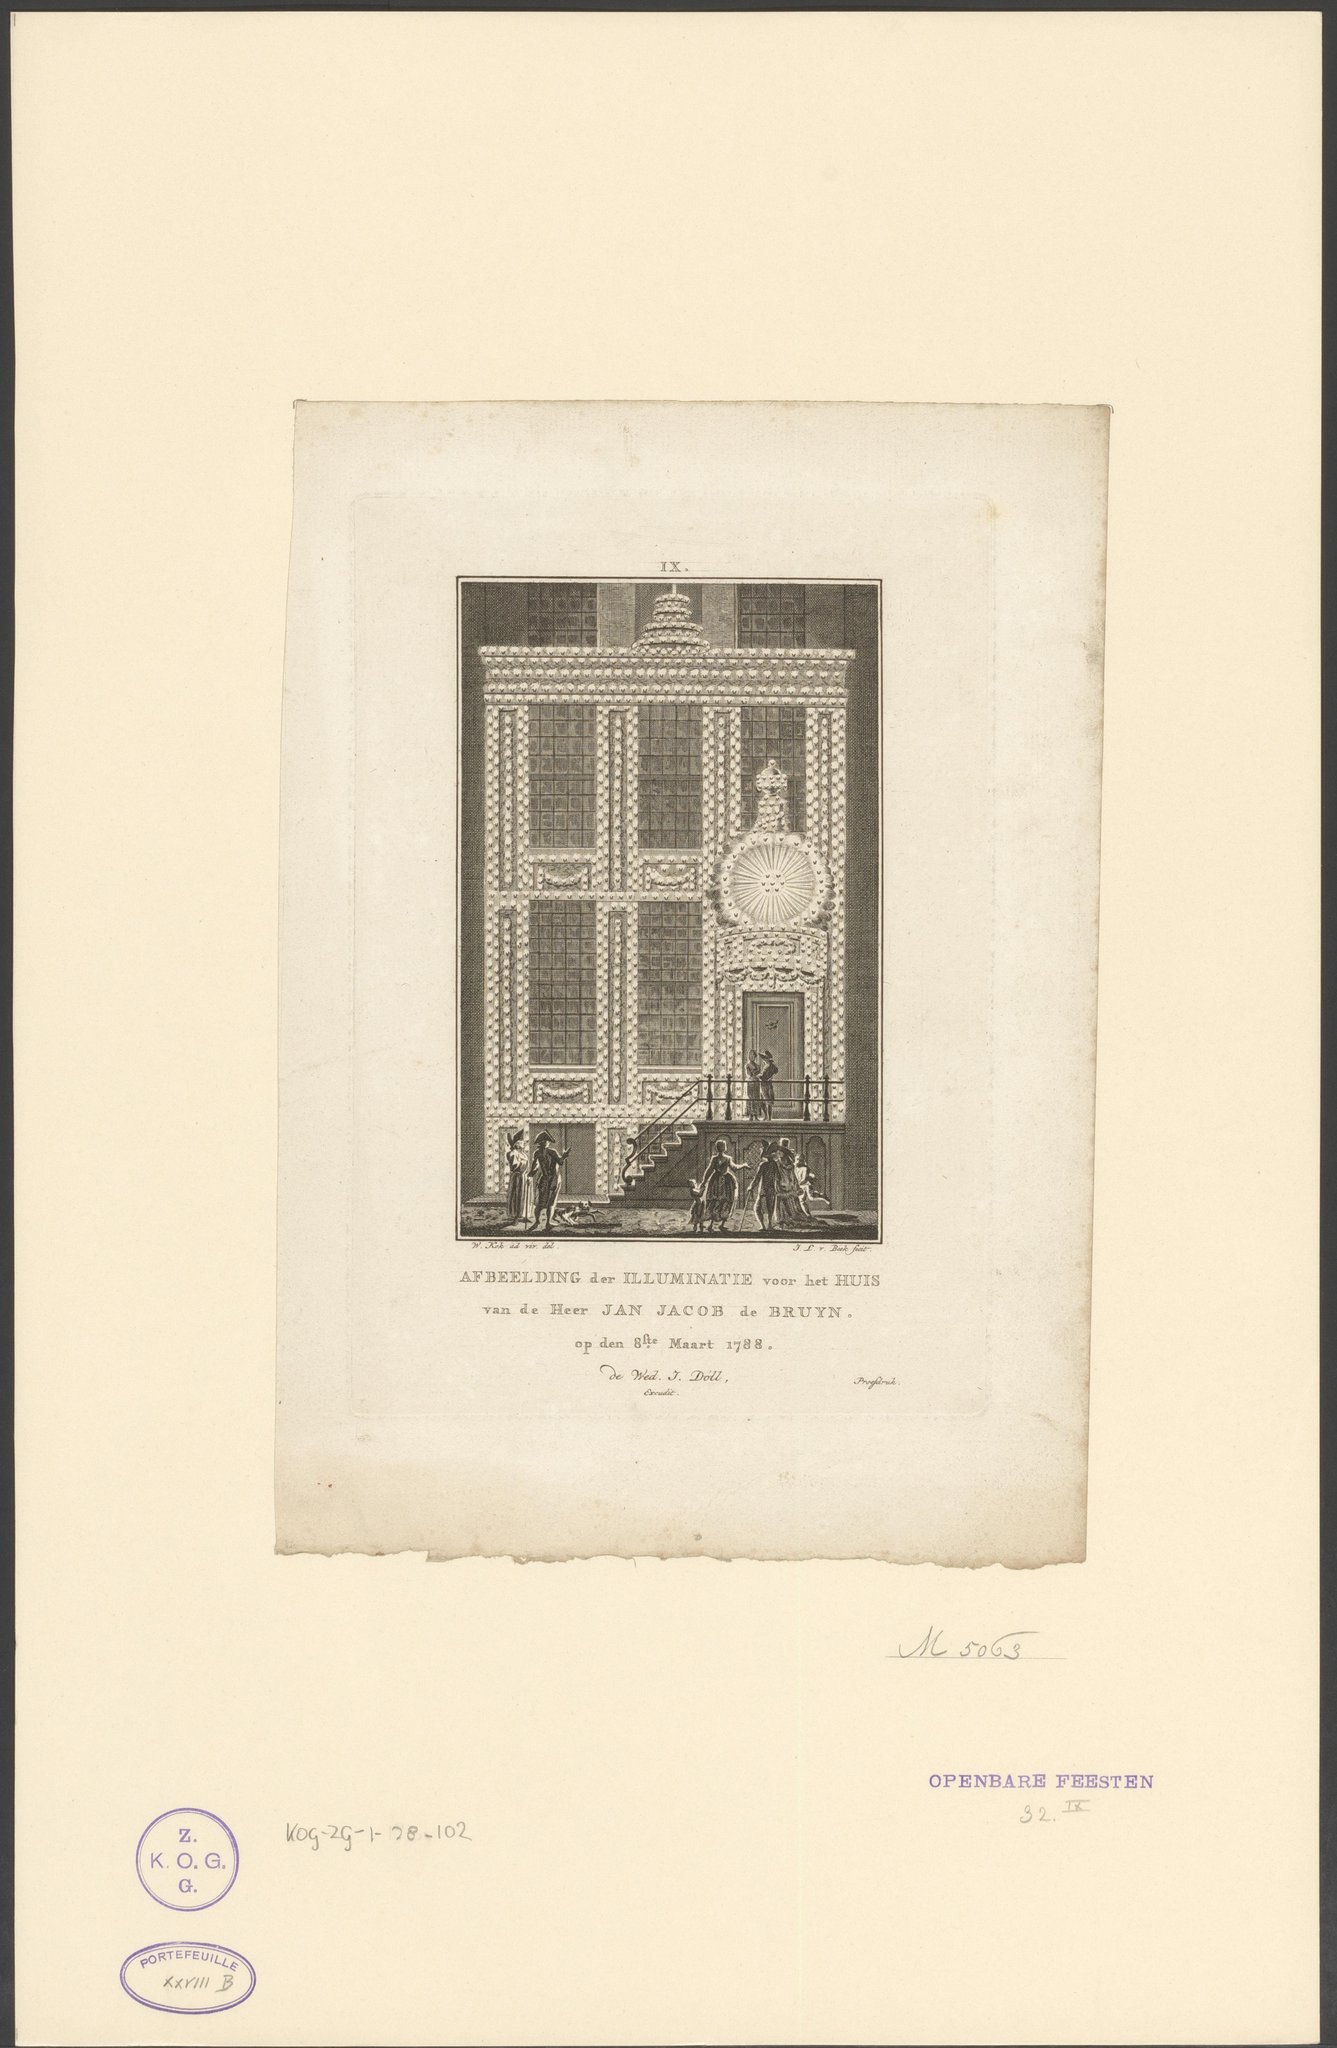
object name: print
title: Afbeelding der Illuminatie voor het Huis van de Heer Jan Jacob de Bruyn op den 8ste Maart 1788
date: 1788-1790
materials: paper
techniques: engraving, etching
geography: amsterdam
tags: the hague, william v (prince of orange), jan jacob de bruyn, bonfire, fire-works (+ festive decoration ~ festive activities), amsterdam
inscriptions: stamp, stamp, collector's mark: Lugt 1641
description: Illuminatie aangebracht voor het huis van Jan Jacob de Bruyn aan de Keizersgracht te Amsterdam. Genummerd bovenaan: IX. Onderdeel van een reeks van twaalf platen van de illuminaties en decoraties te Amsterdam op de 40ste verjaardag van prins Willem V op 8 maart 1788. Onderwerpsrubrieken binnen de Atlas Zeden en Gewoonten: Zeden en Gewoonten in Engeren Zin. Volksleven. Openbare feesten. Vorstelijke intochten, (Illuminaties, vuurwerken en dergelijke, openbare feesten).